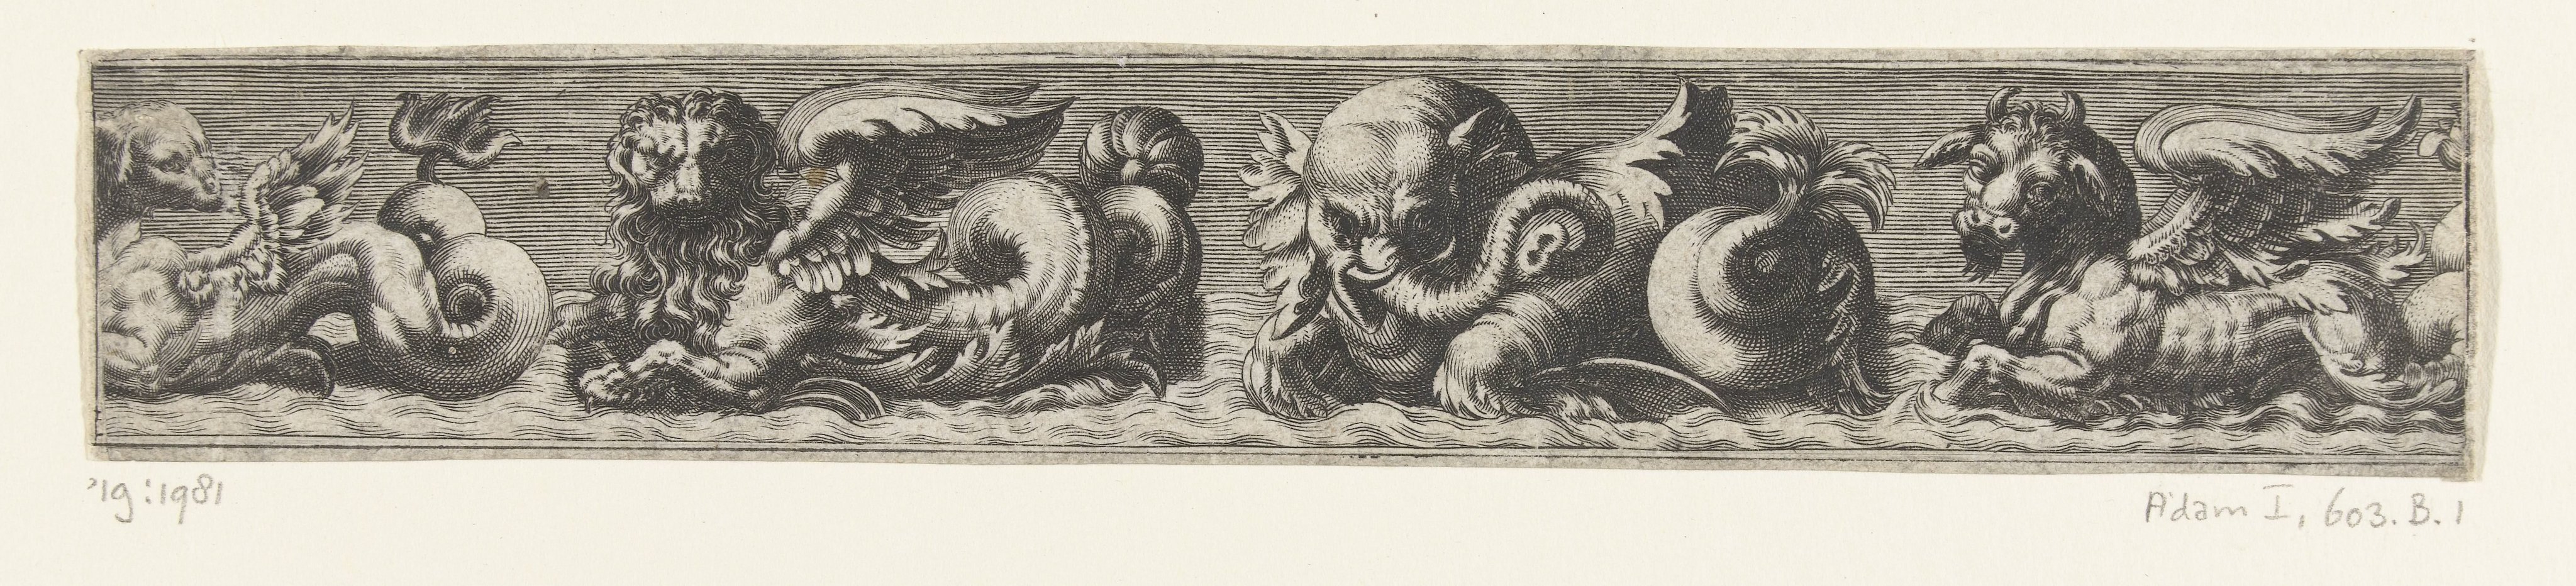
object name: ornament print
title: Friezen met zeemonsters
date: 1580-1623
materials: paper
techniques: engraving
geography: germany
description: Tegenzijdige kopieën naar de volgende prenten: RP-P-1984-447, RP-P-1984-440, RP-P-1984-441 en RP-P-1984-439. Blad uit serie van 6.